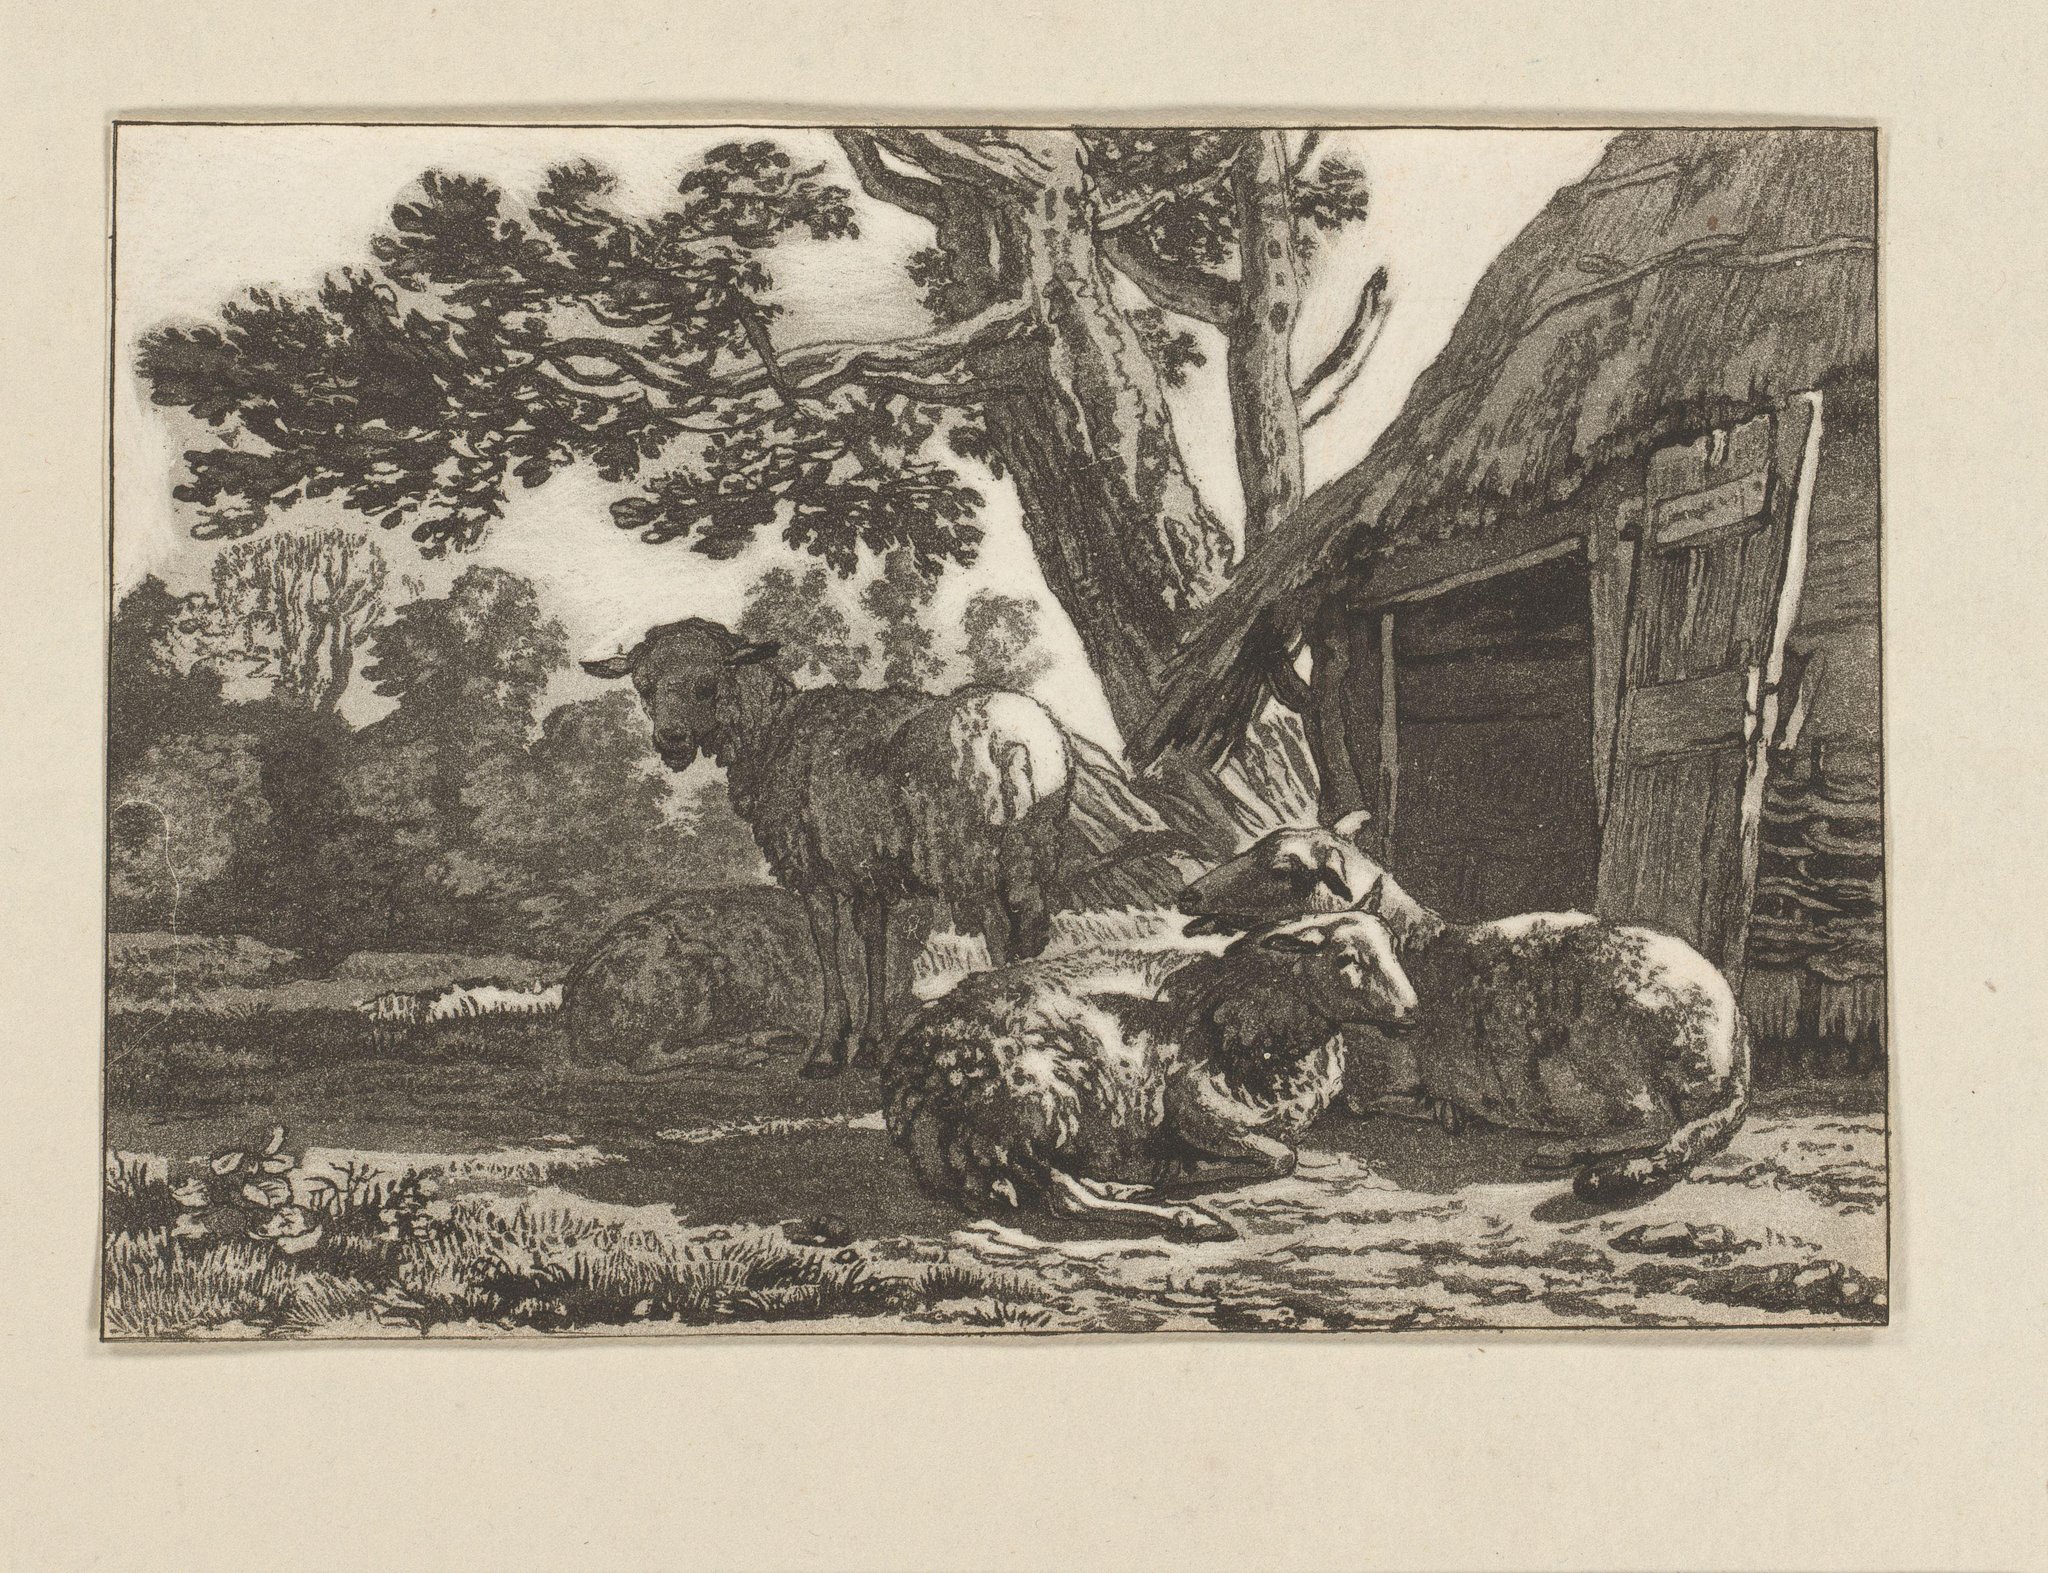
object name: print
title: Schaapskooi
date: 1781-1787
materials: paper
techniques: transfer, print drawing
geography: amsterdam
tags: sheep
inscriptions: collector's mark: ‘RIJKS / MUSM’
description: Vier schapen bij de geopende schaapskooi. De prent ligt los in een album, zie blad 44.